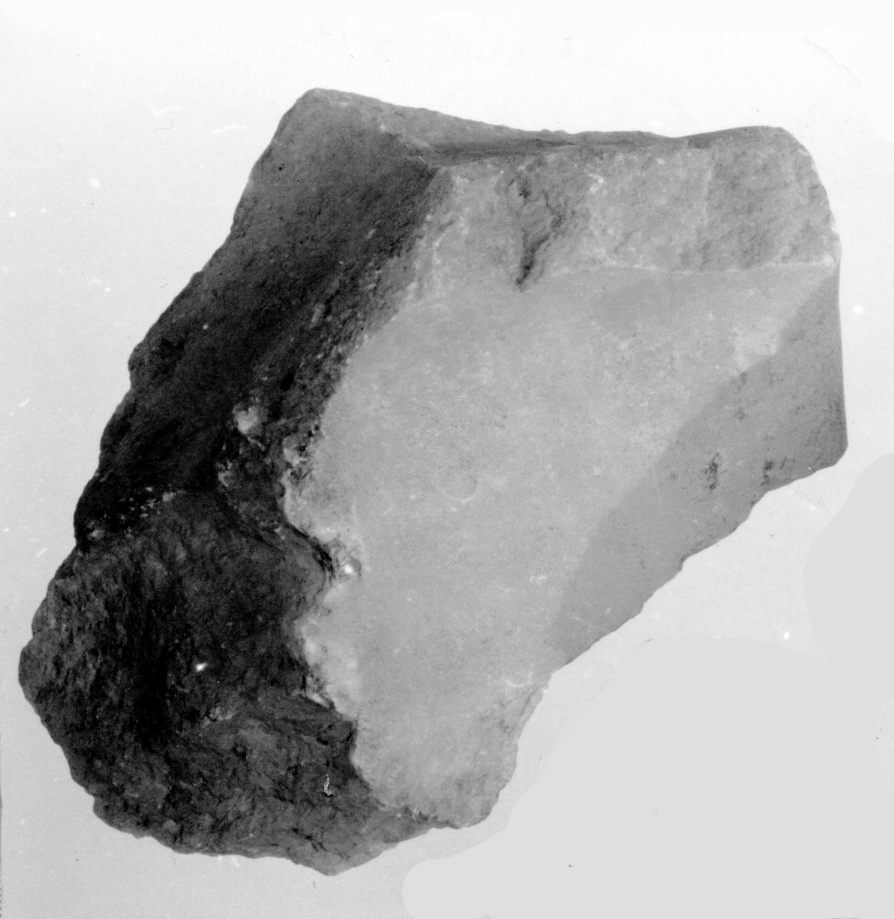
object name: canopic box, siptah, top rim, inner corner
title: Fragment of the Canopic Chest of Siptah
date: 1194-1188 BCE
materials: stone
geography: egypt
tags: sarcophagus